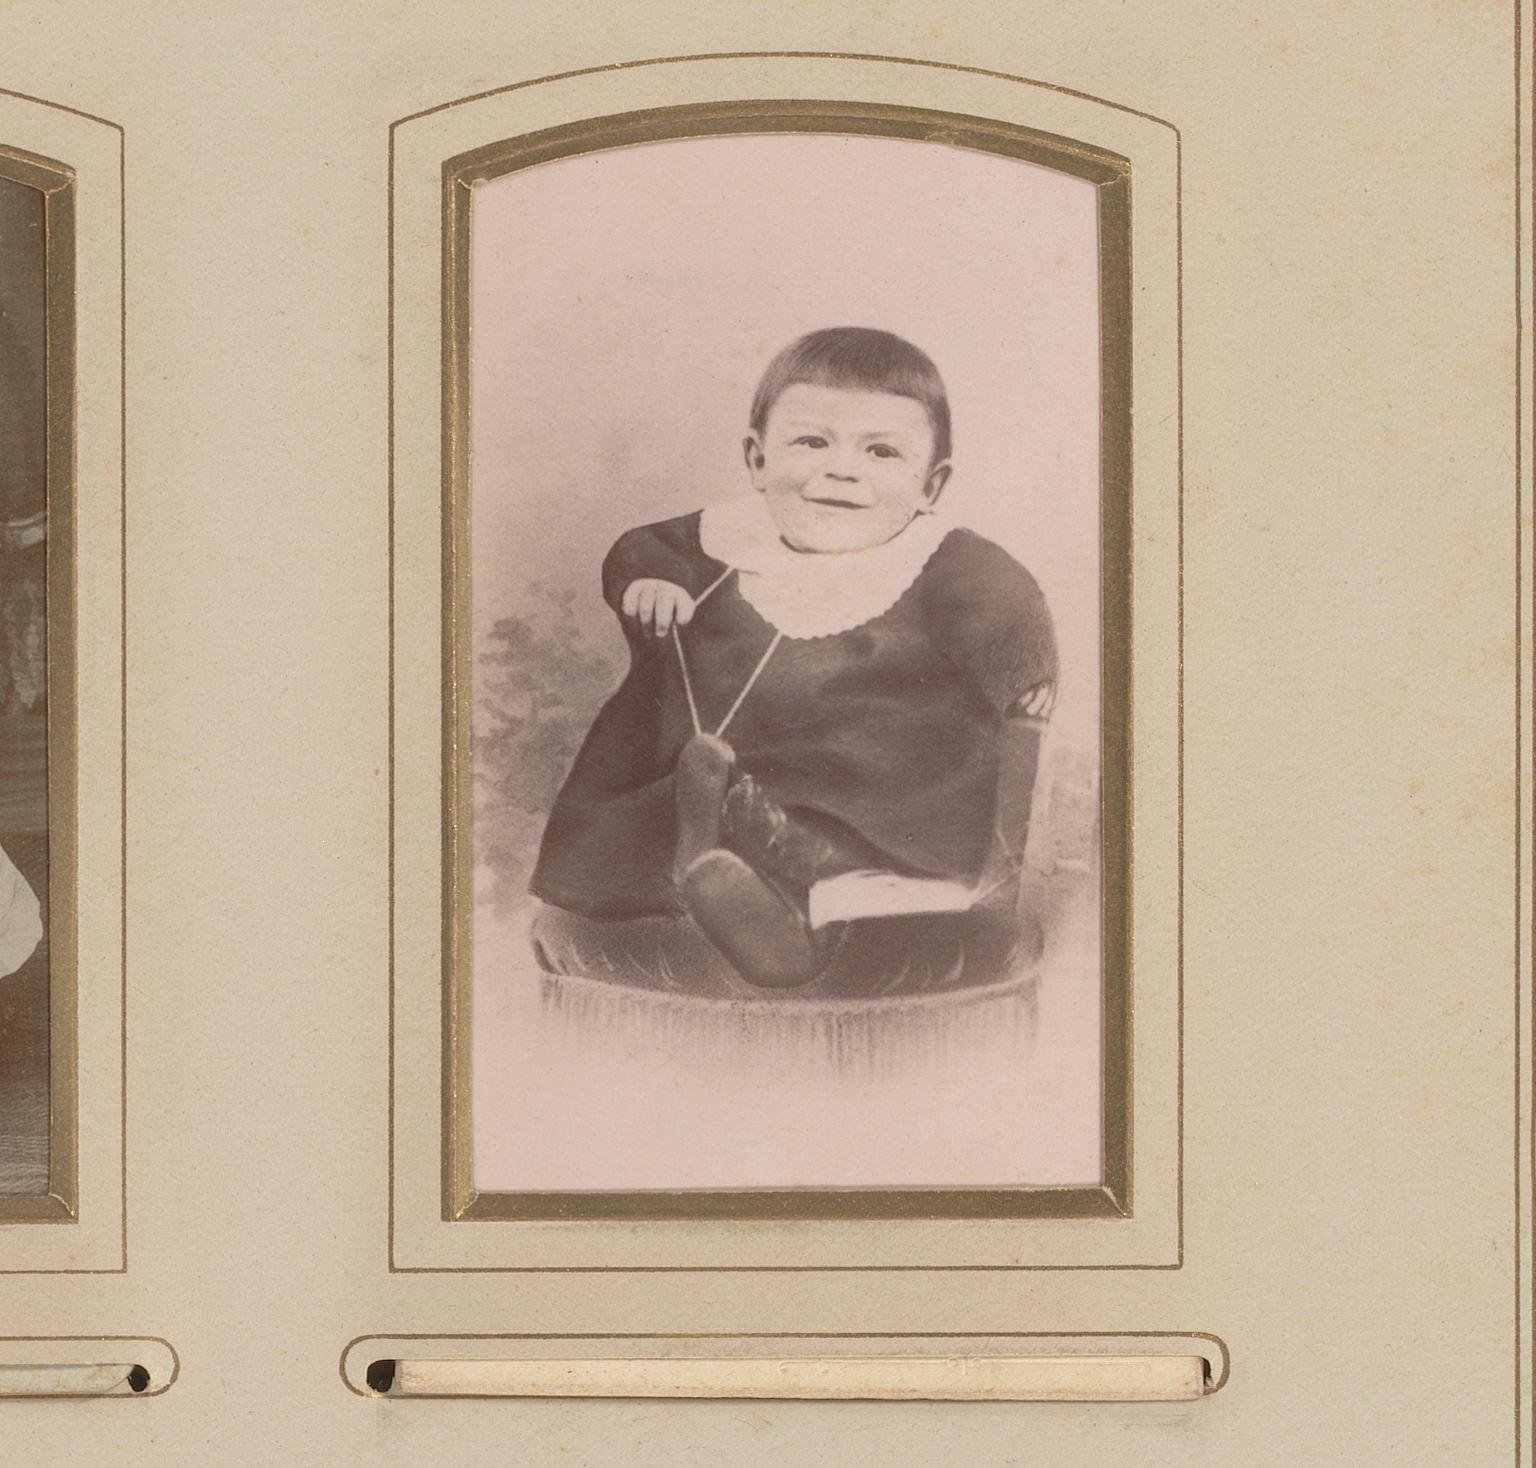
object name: photograph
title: Fotoreproductie van een getekend portret van een zittend kind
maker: léon bichon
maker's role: fotograaf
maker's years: 1859-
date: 1880-1920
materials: cardboard, photographic support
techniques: collodion silver print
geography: saint-germain-en-laye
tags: sitting figure, child, historical persons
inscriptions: inscription: ‘Photographie/ DU MUSÉE/ Mson Veber/ Léon Bichon/ SUCCESSEUR/ 2me PHOTOGRAPHIE/ DE LA/ Rue de la République, 46/ (Maison de la Véranda)/ St. GERMAIN en LAYE’